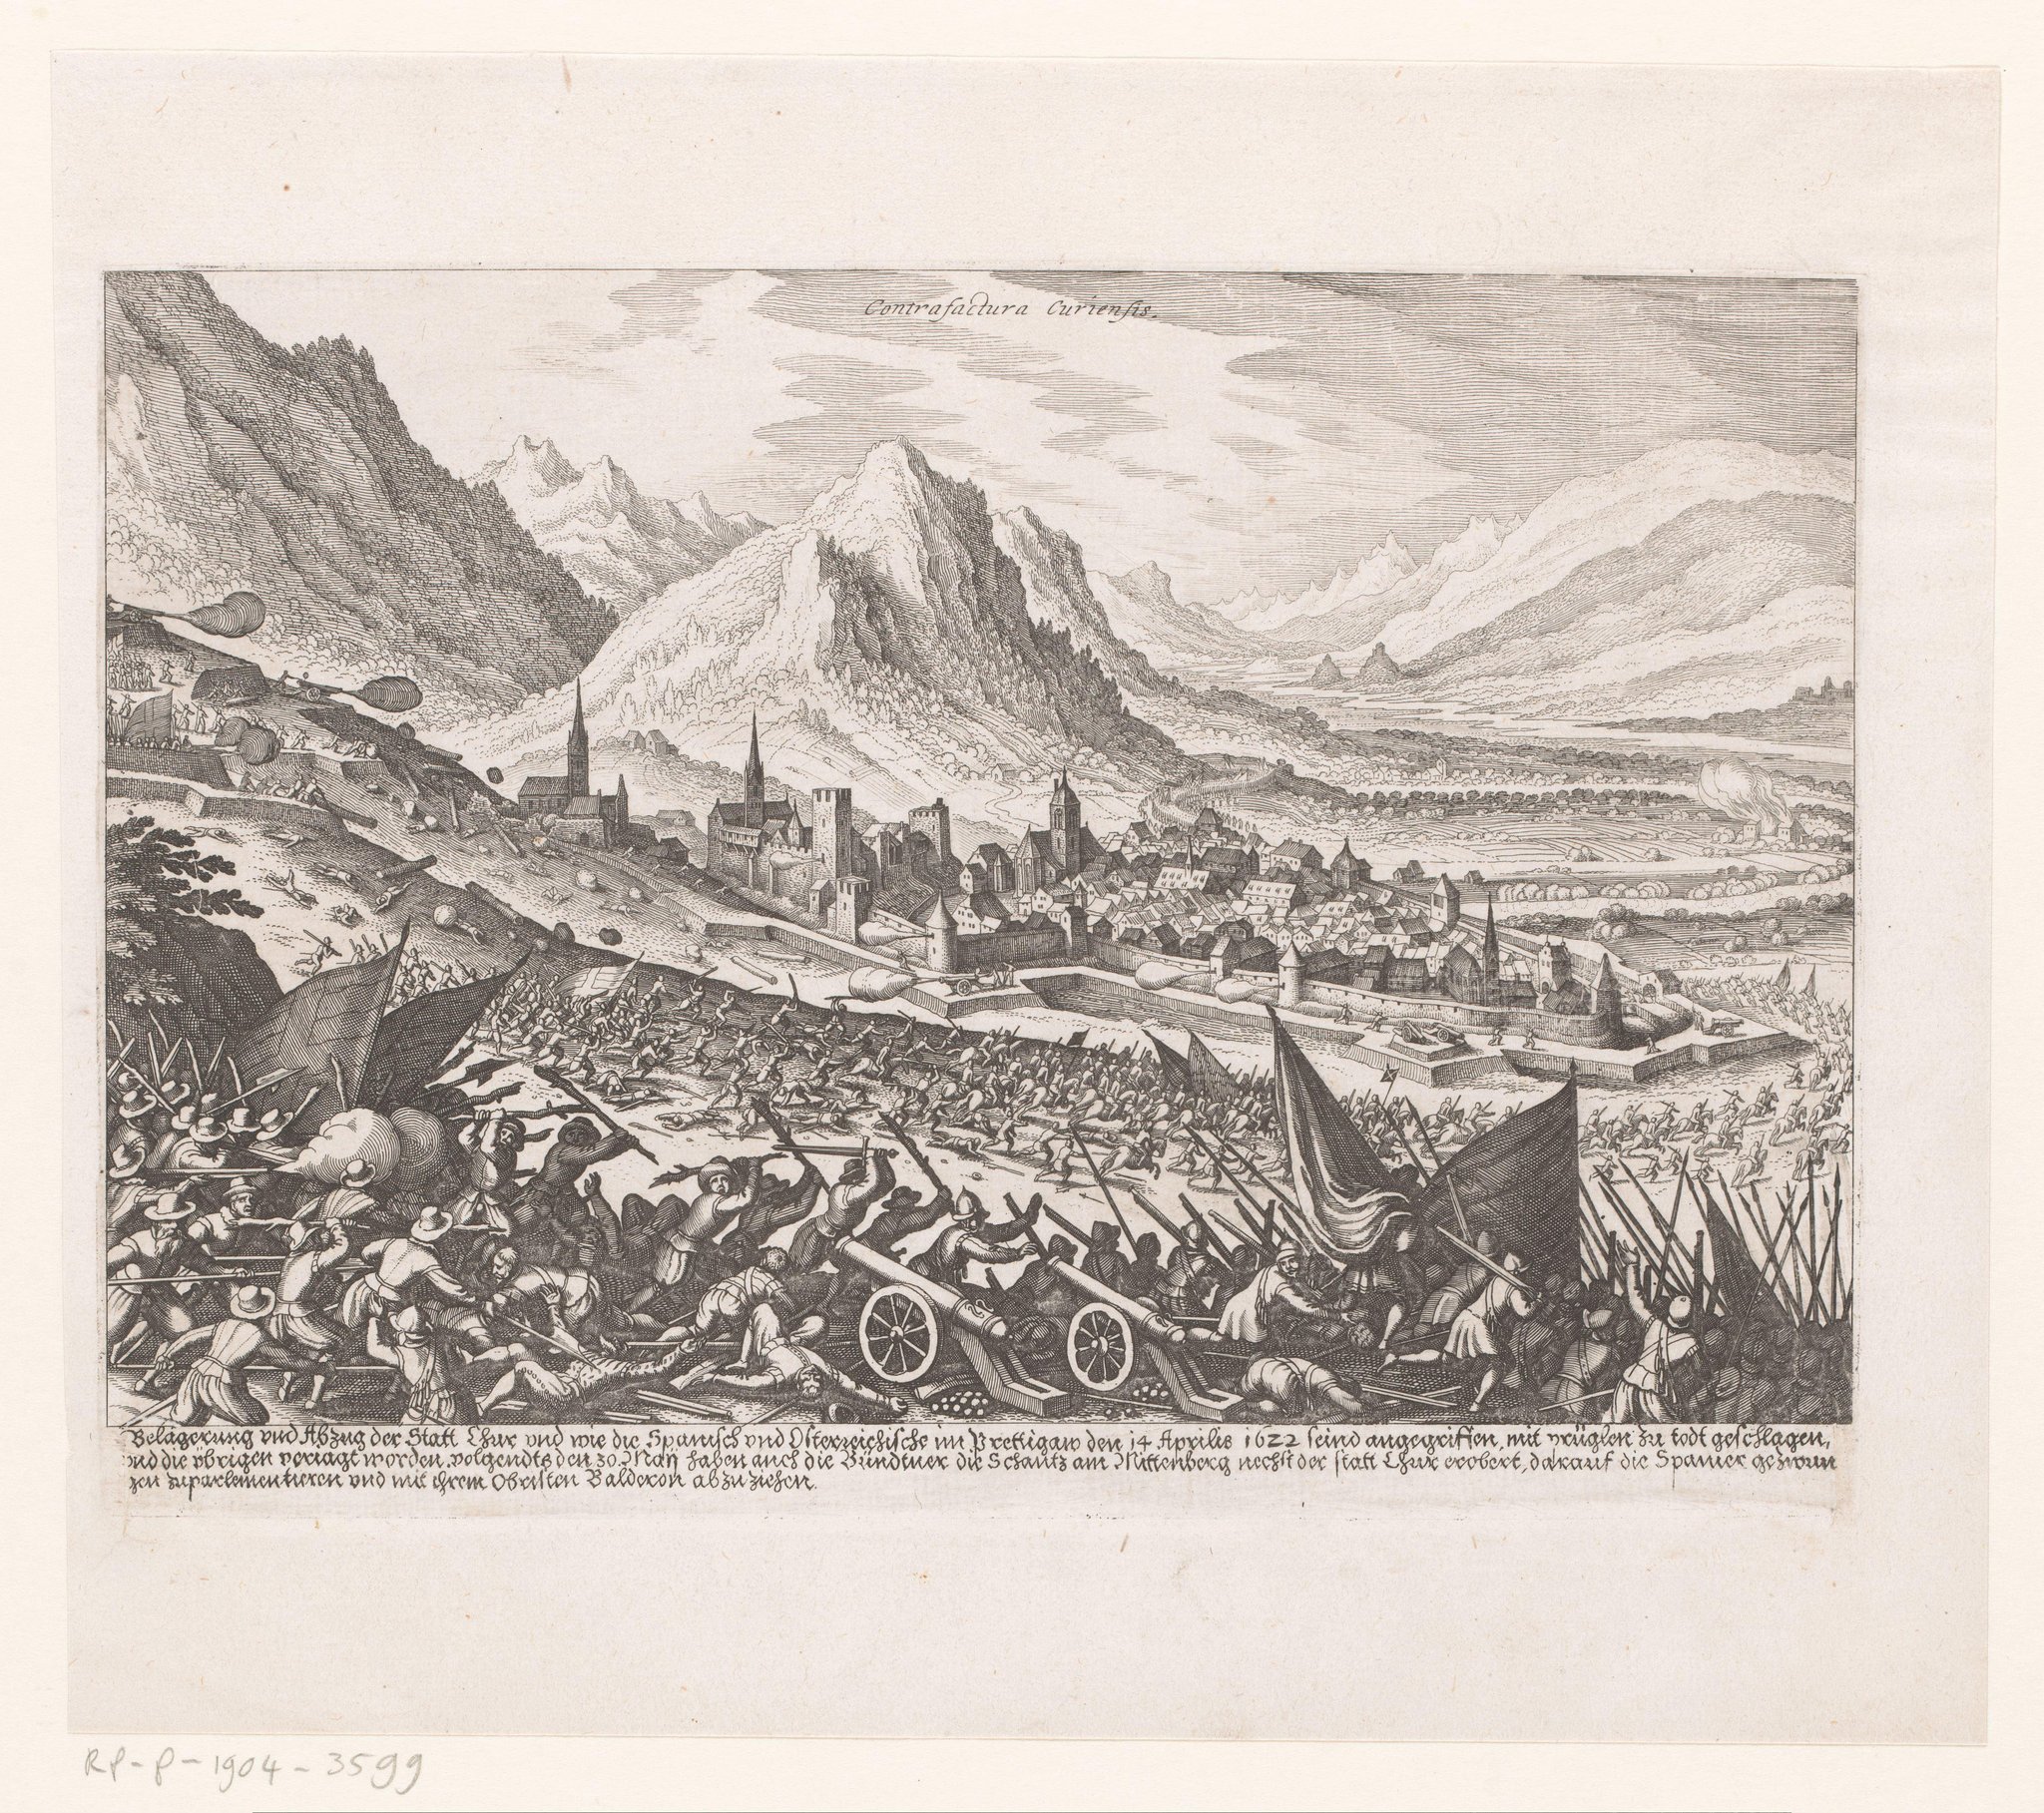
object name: print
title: Contrafactura Curiensis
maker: matthäus merian (i)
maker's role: print maker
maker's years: 1593-1650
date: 1622-1650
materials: paper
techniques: etching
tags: hand-to-hand fighting (~ battle), siege, mountains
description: Het beleg van Chur vond plaats op 14-22 april 1622, tussen de Spaans-Oostenrijkse alliantie en het Zwitsers bondgenootschap.